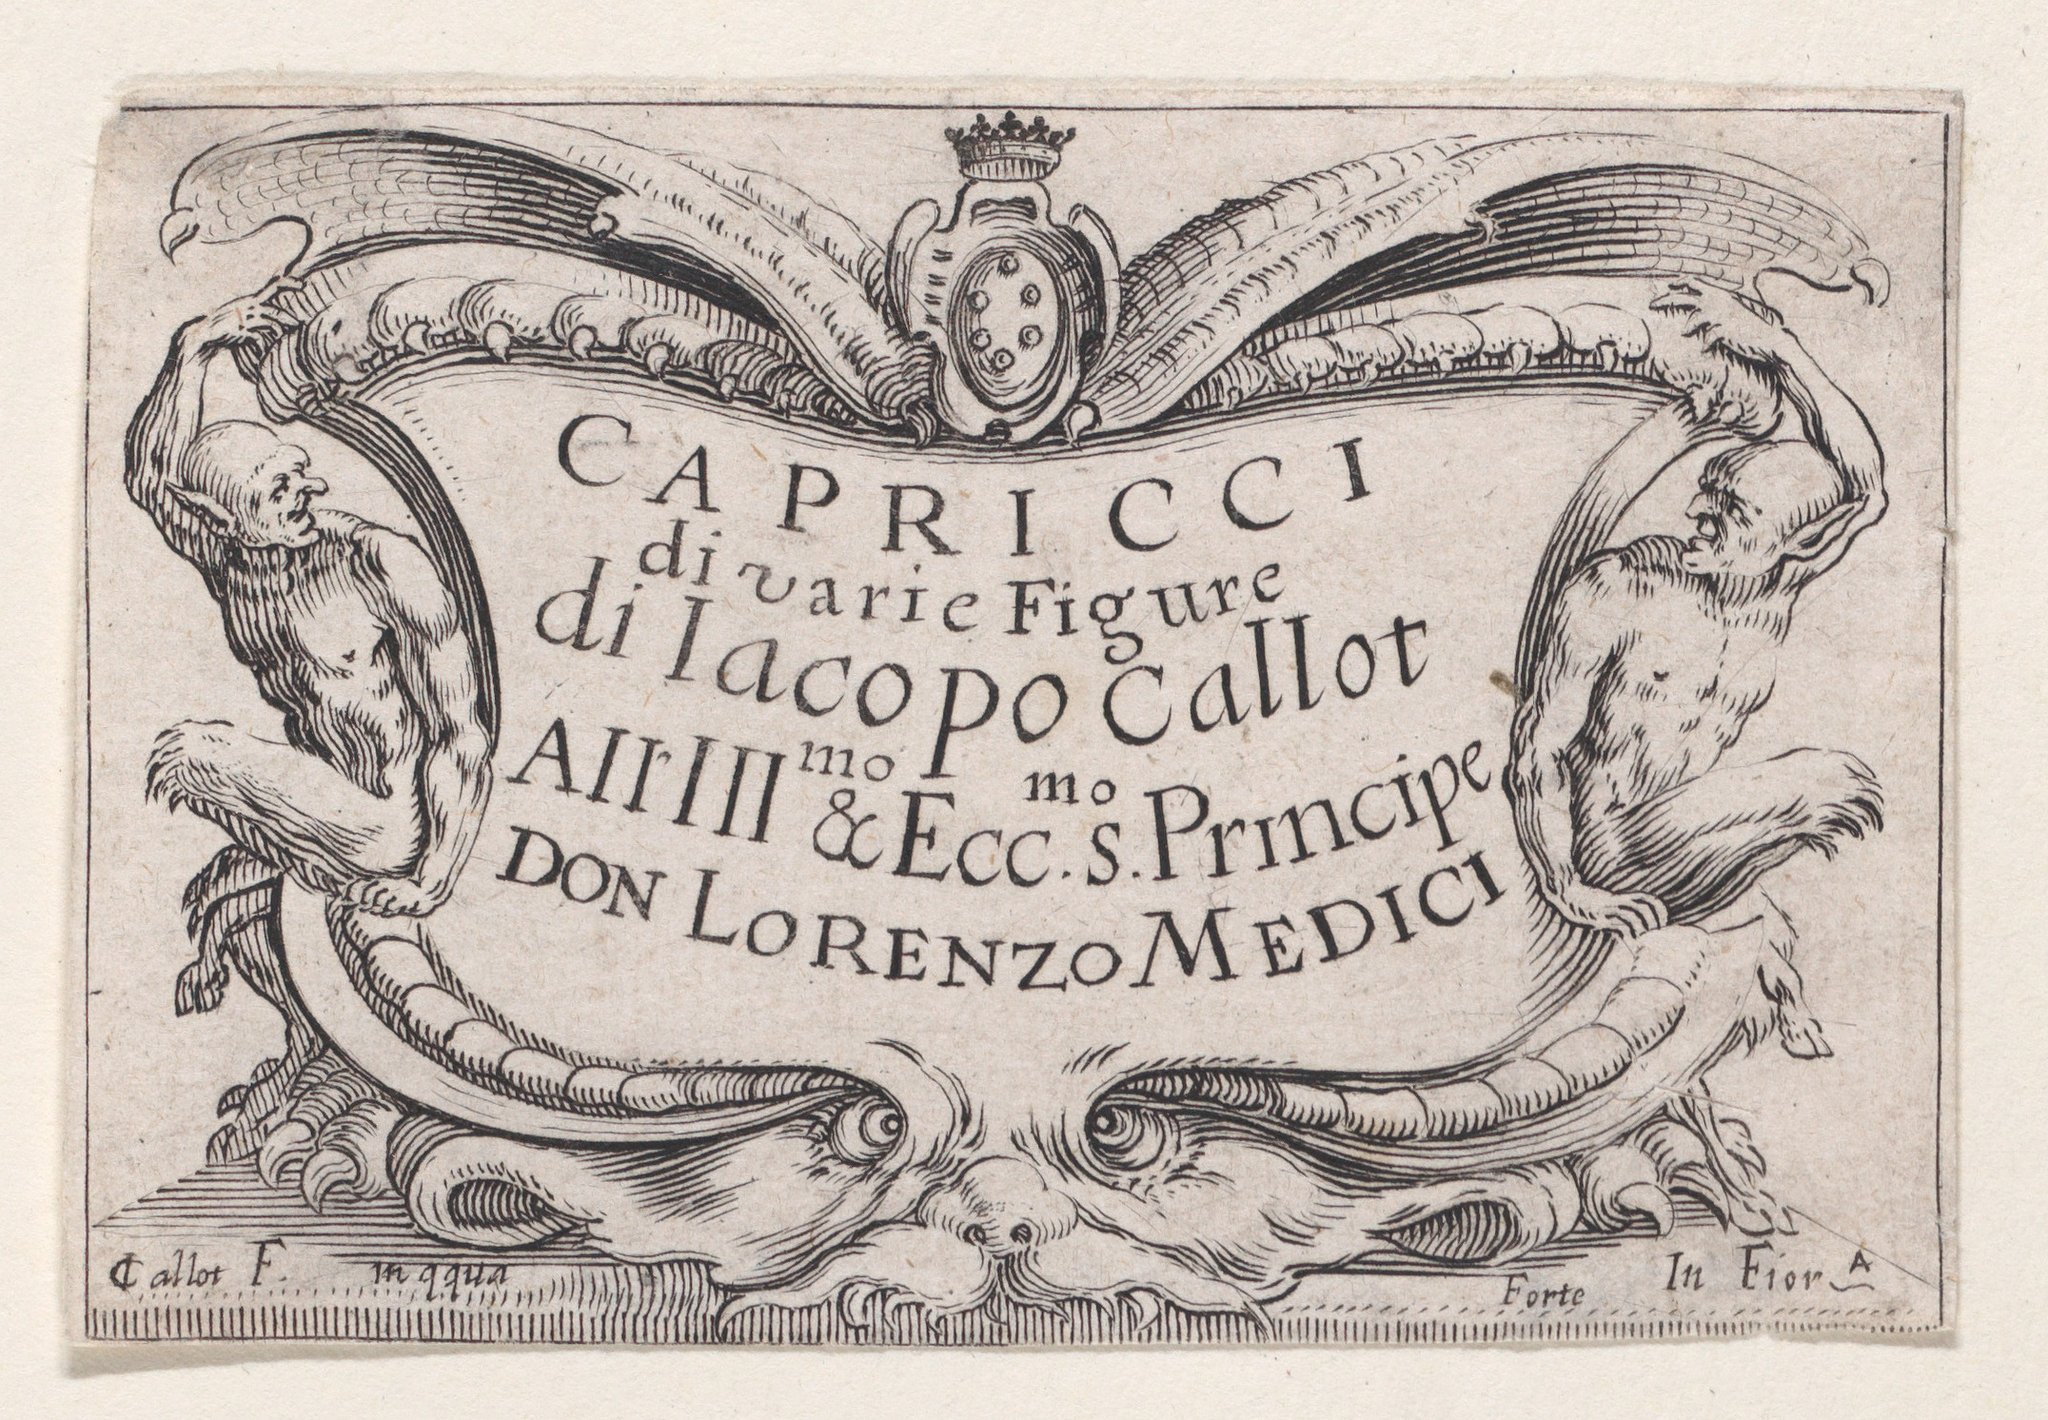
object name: print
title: Copy of Frontispiece, from "Les Caprices" Series A, The Florence Set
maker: Anonymous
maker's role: artist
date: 1601-1700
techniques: etching